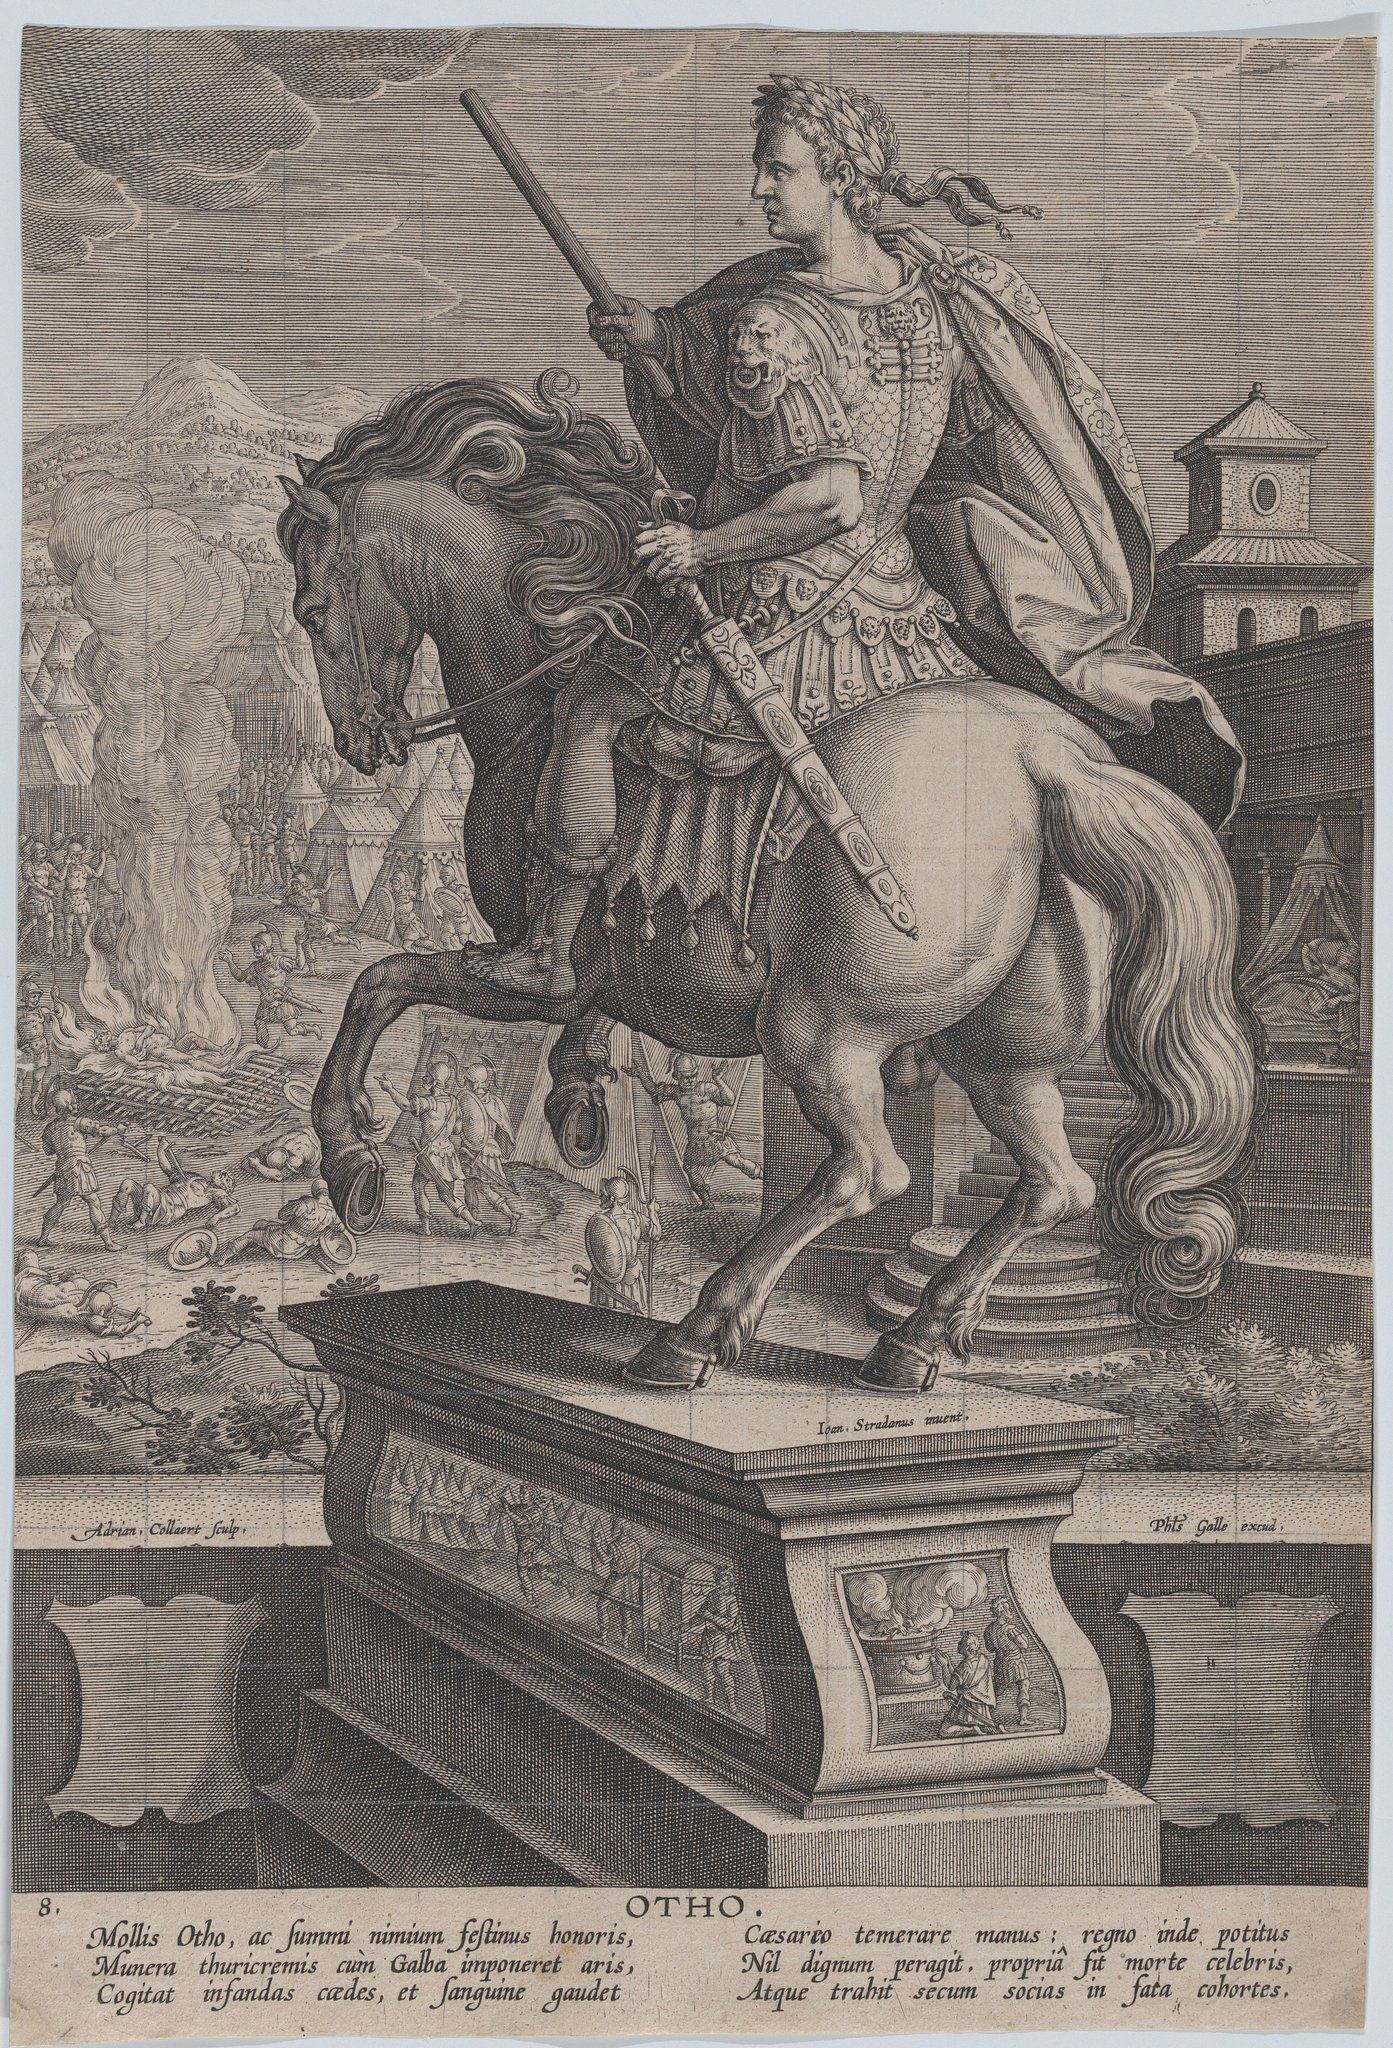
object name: print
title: Plate 8: equestrian statue of Otho, seen from behind, his death scene in the background with him stabbing himself at right and the burning of his body at left, from 'Roman Emperors on Horseback'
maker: adriaen collaert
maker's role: artist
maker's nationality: netherlandish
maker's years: 1560-1618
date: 1587-1589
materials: graphite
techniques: engraving, drawing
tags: sculpture,battles,swords,men,horses